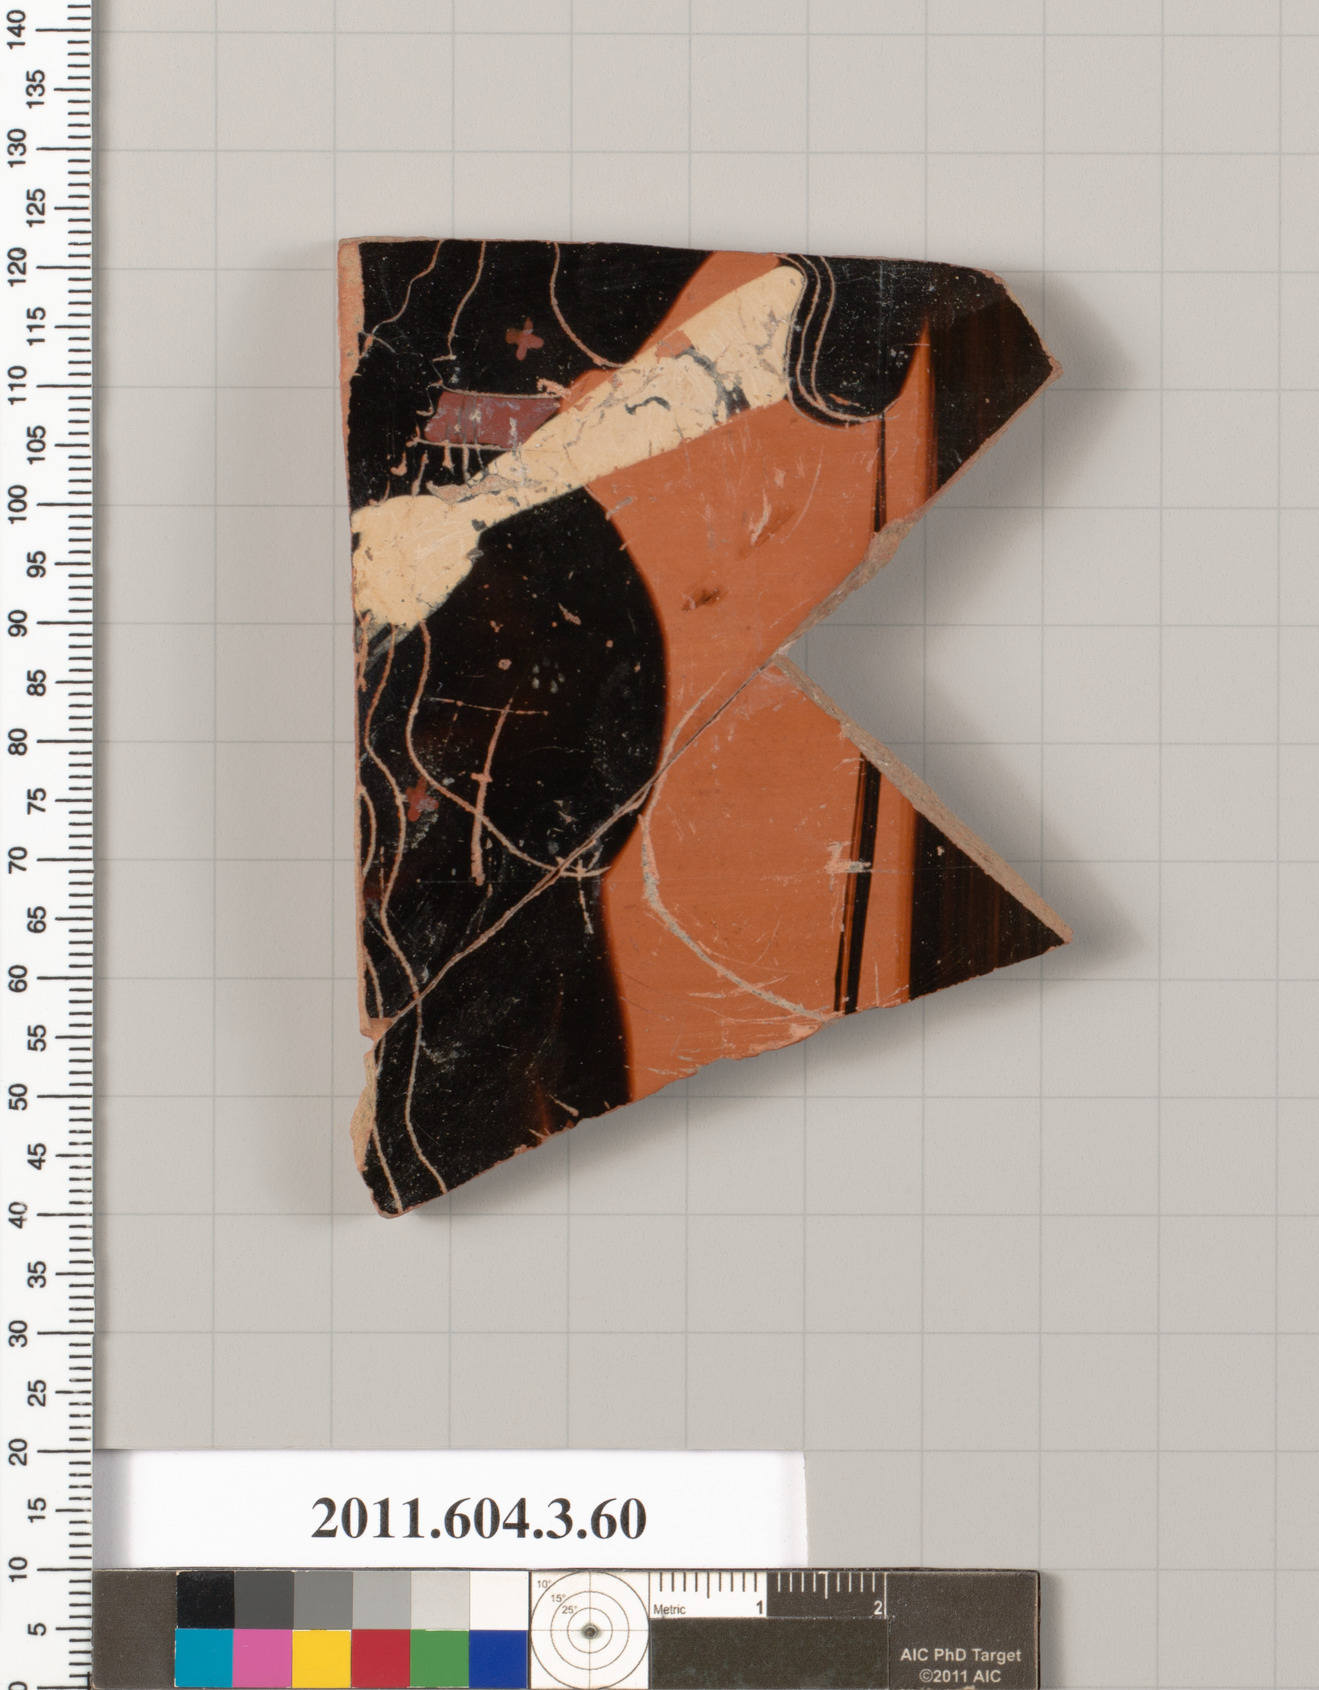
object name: amphora fragment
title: Terracotta fragment of an amphora (jar)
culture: greek, attic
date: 433-567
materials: terracotta